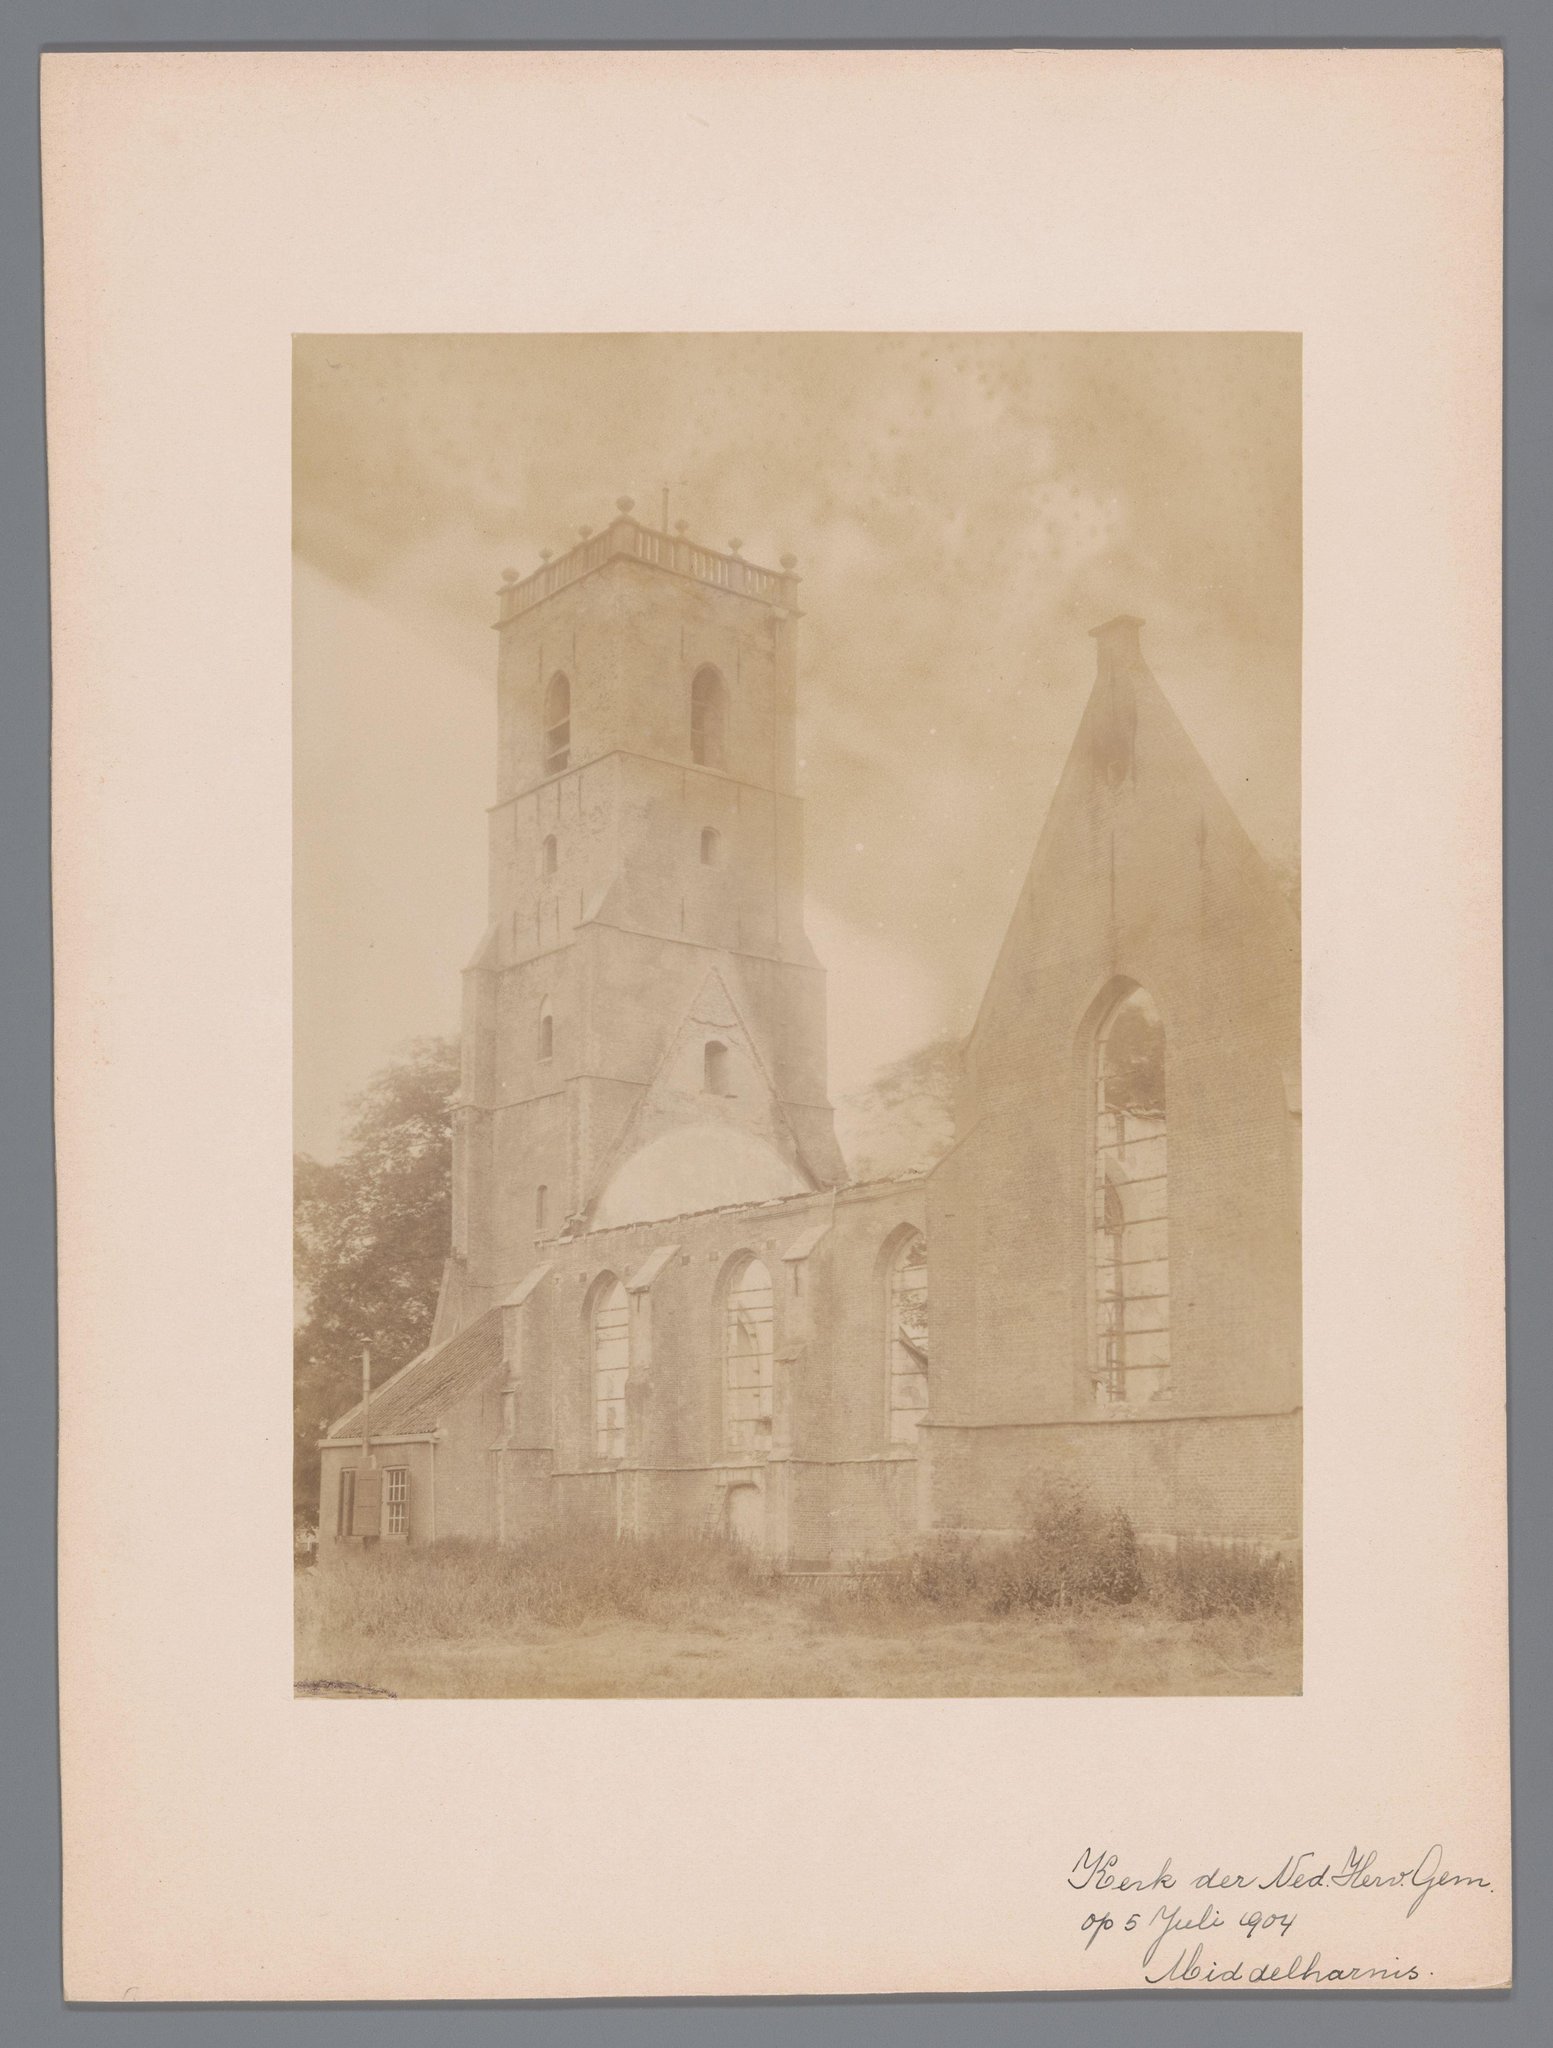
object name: photograph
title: Gezicht op de Hervormde Kerk te Middelharnis na de brand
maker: anoniem (monumentenzorg)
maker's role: fotograaf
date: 1904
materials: cardboard, photographic support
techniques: albumen print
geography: middelharnis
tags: church (exterior)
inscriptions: annotation: ‘Kerk der Ned. Herv. Gem./ op 5 Juli 1904/ Middelharnis’, annotation: ‘Middelharnis (Z.H.)/ Kerk der Ned. Herv. gemeente/ op 5 Juli 1904’